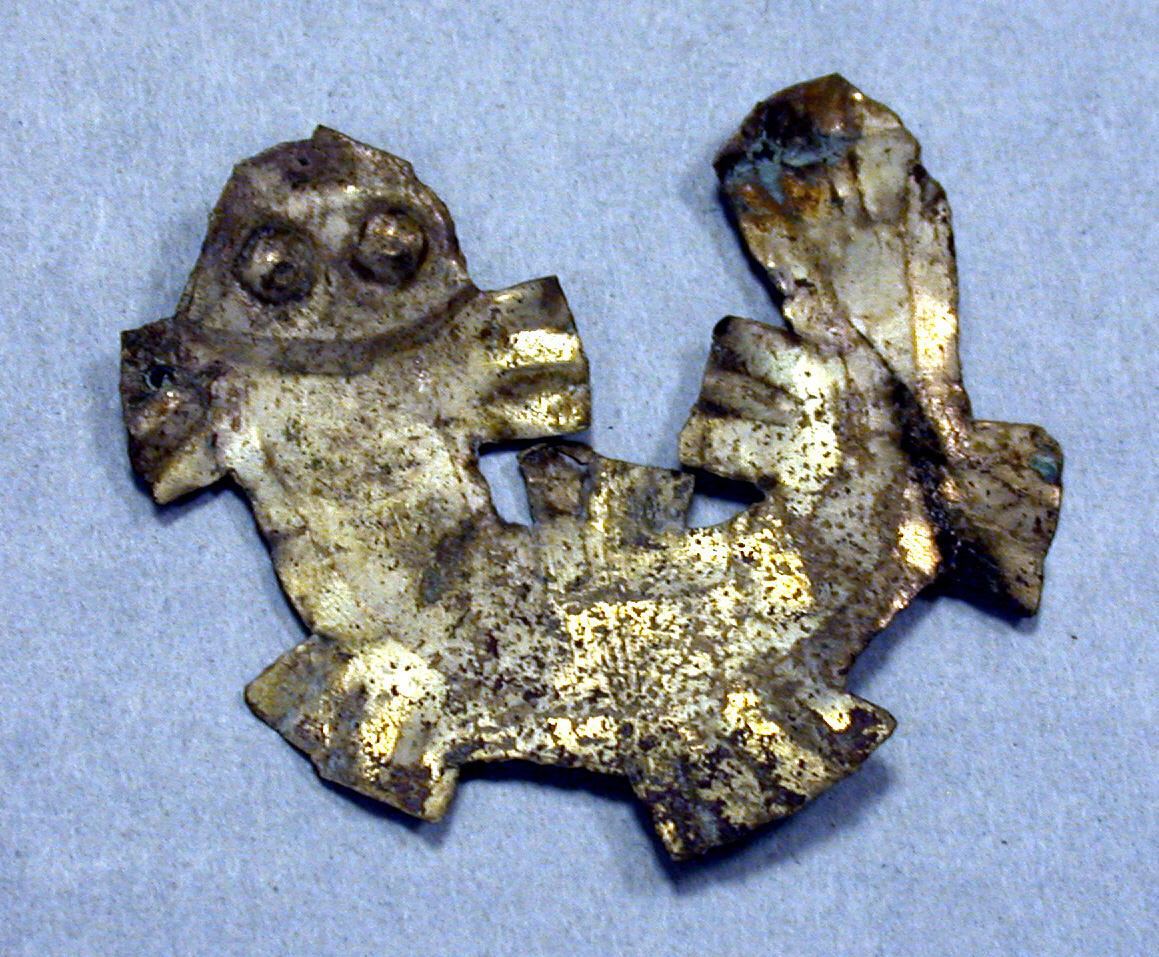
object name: ornament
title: Fish Ornament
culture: peruvian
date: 1001-1200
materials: silver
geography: peru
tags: fish